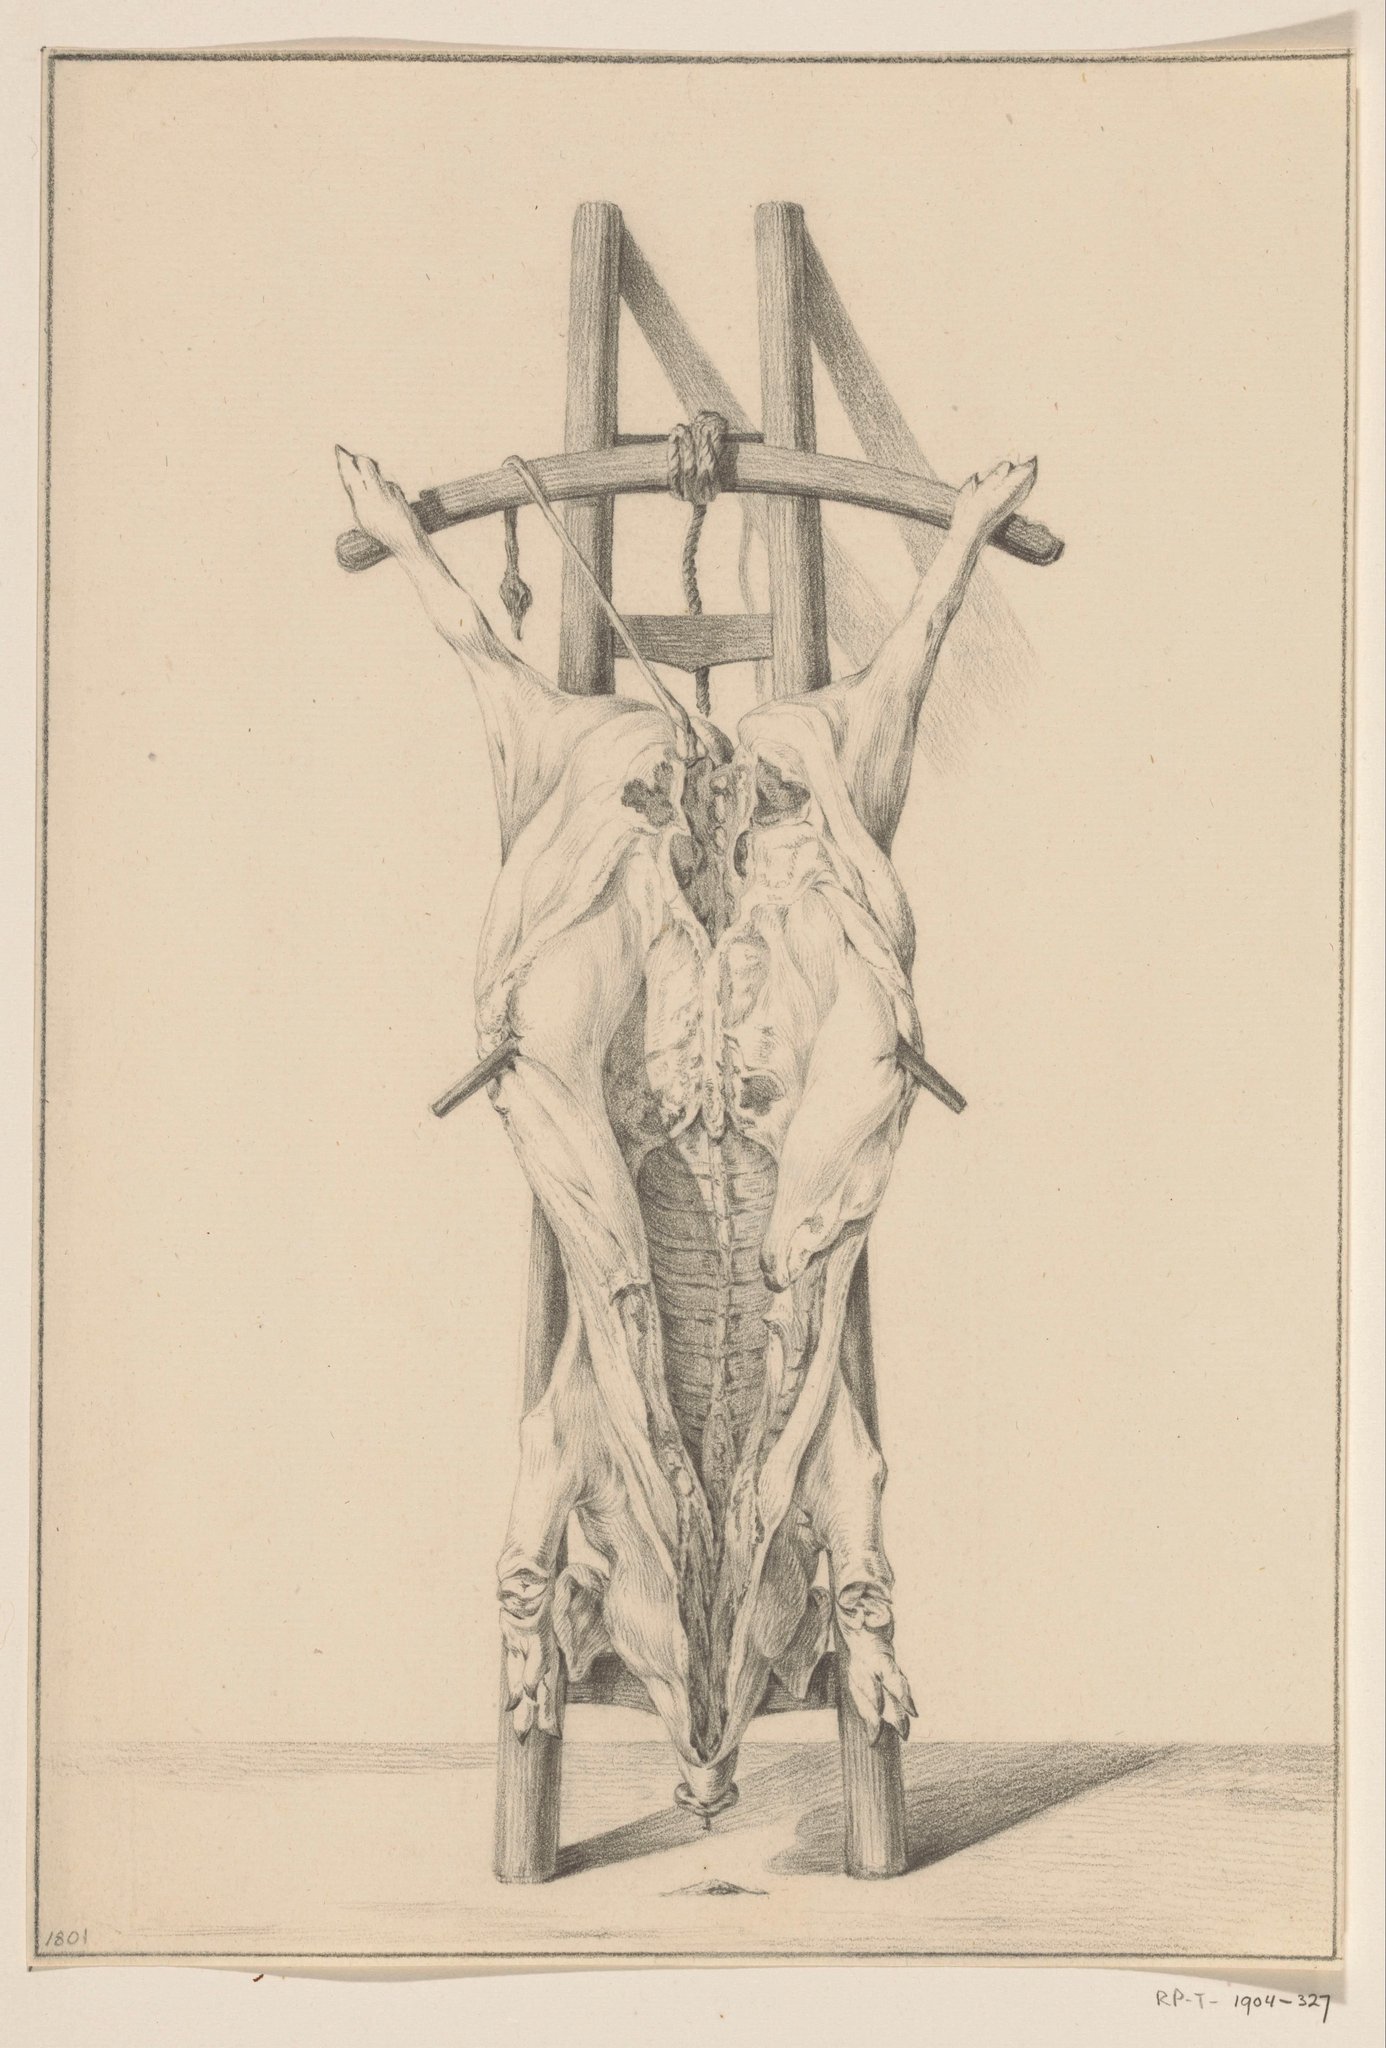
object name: drawing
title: Geslacht varken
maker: jean bernard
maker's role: draughtsman, print maker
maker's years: 1765-1833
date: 1801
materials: chalk, paper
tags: pig (+ slaughtered animal)